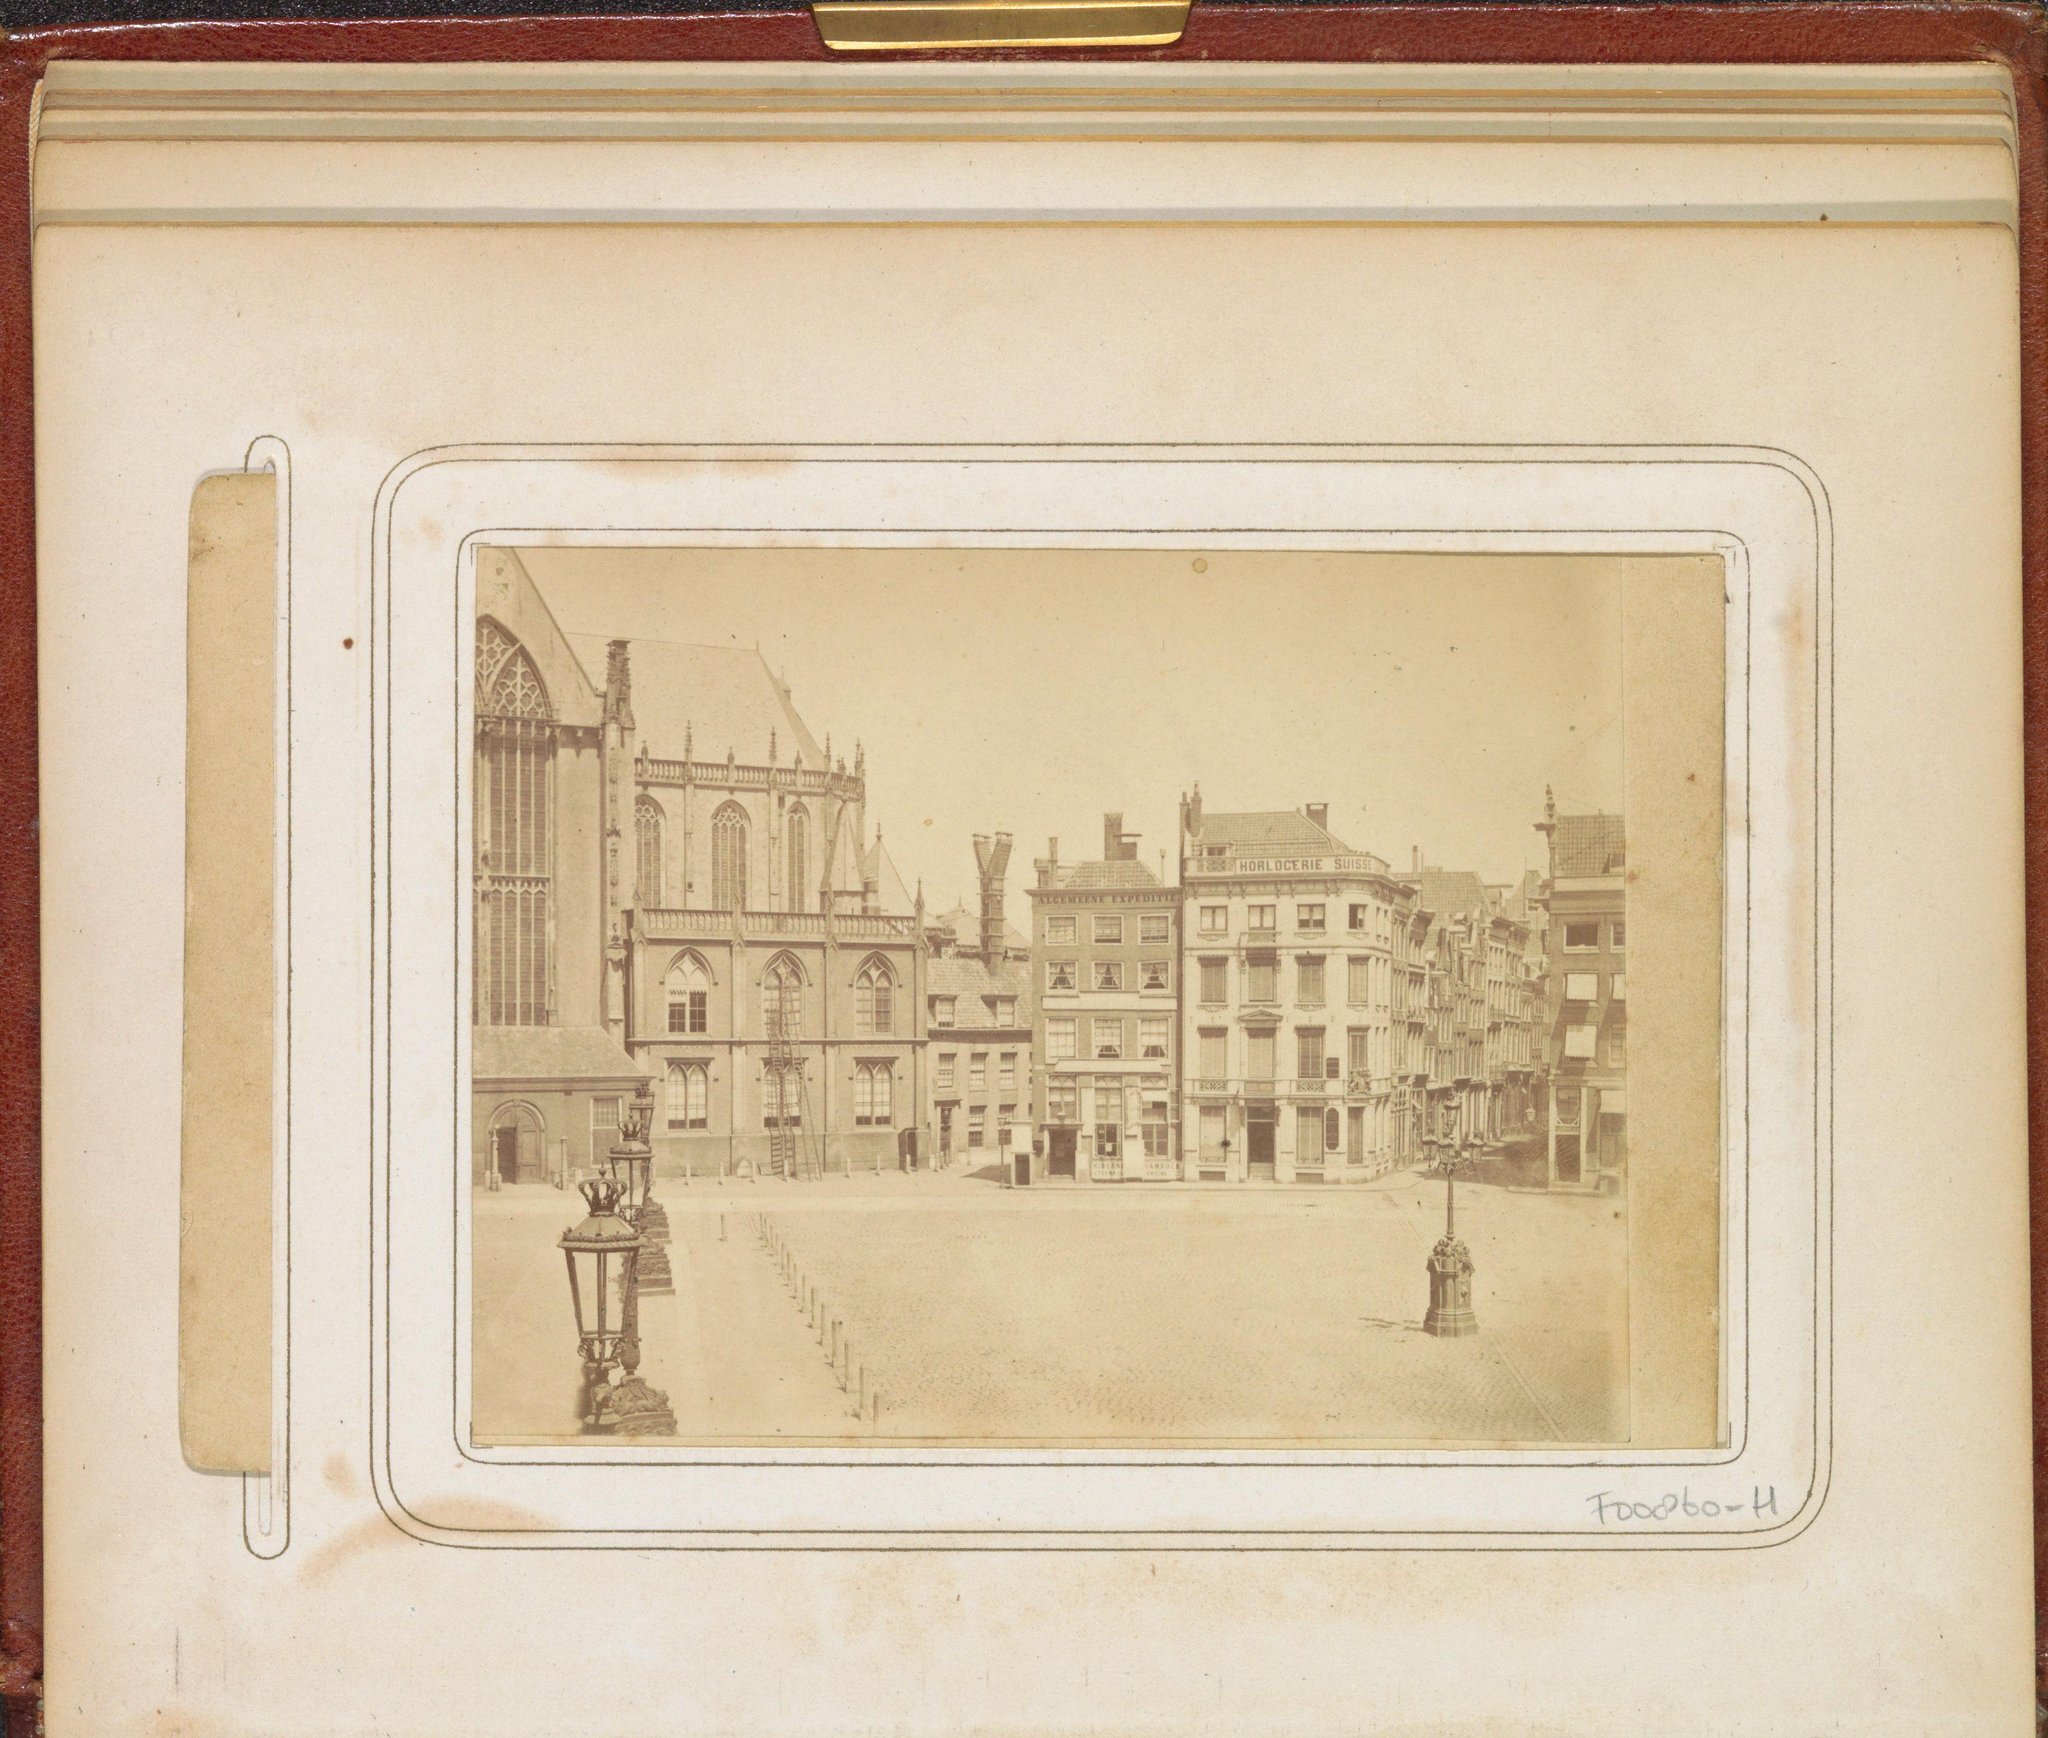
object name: cabinet photograph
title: Noordzijde van de Dam met de Nieuwe Kerk en de ingang van de Nieuwendijk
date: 1850-1875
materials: cardboard, paper, photographic support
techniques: albumen print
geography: amsterdam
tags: façade (of house or building), square, place, circus, etc. (+ city(-scape) with figures, staffage), prospect of city, town panorama, silhouette of city, amsterdam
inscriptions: inscription: ‘Rooswinkel & Co. Dam Amsterdam.’, inscription: ‘Dam.’